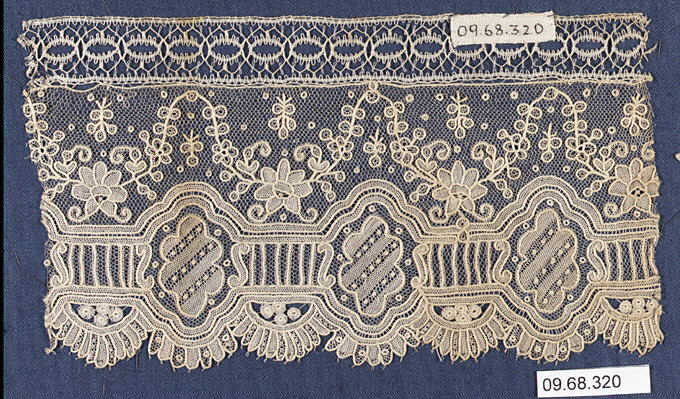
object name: fragment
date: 1801-1900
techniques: lace